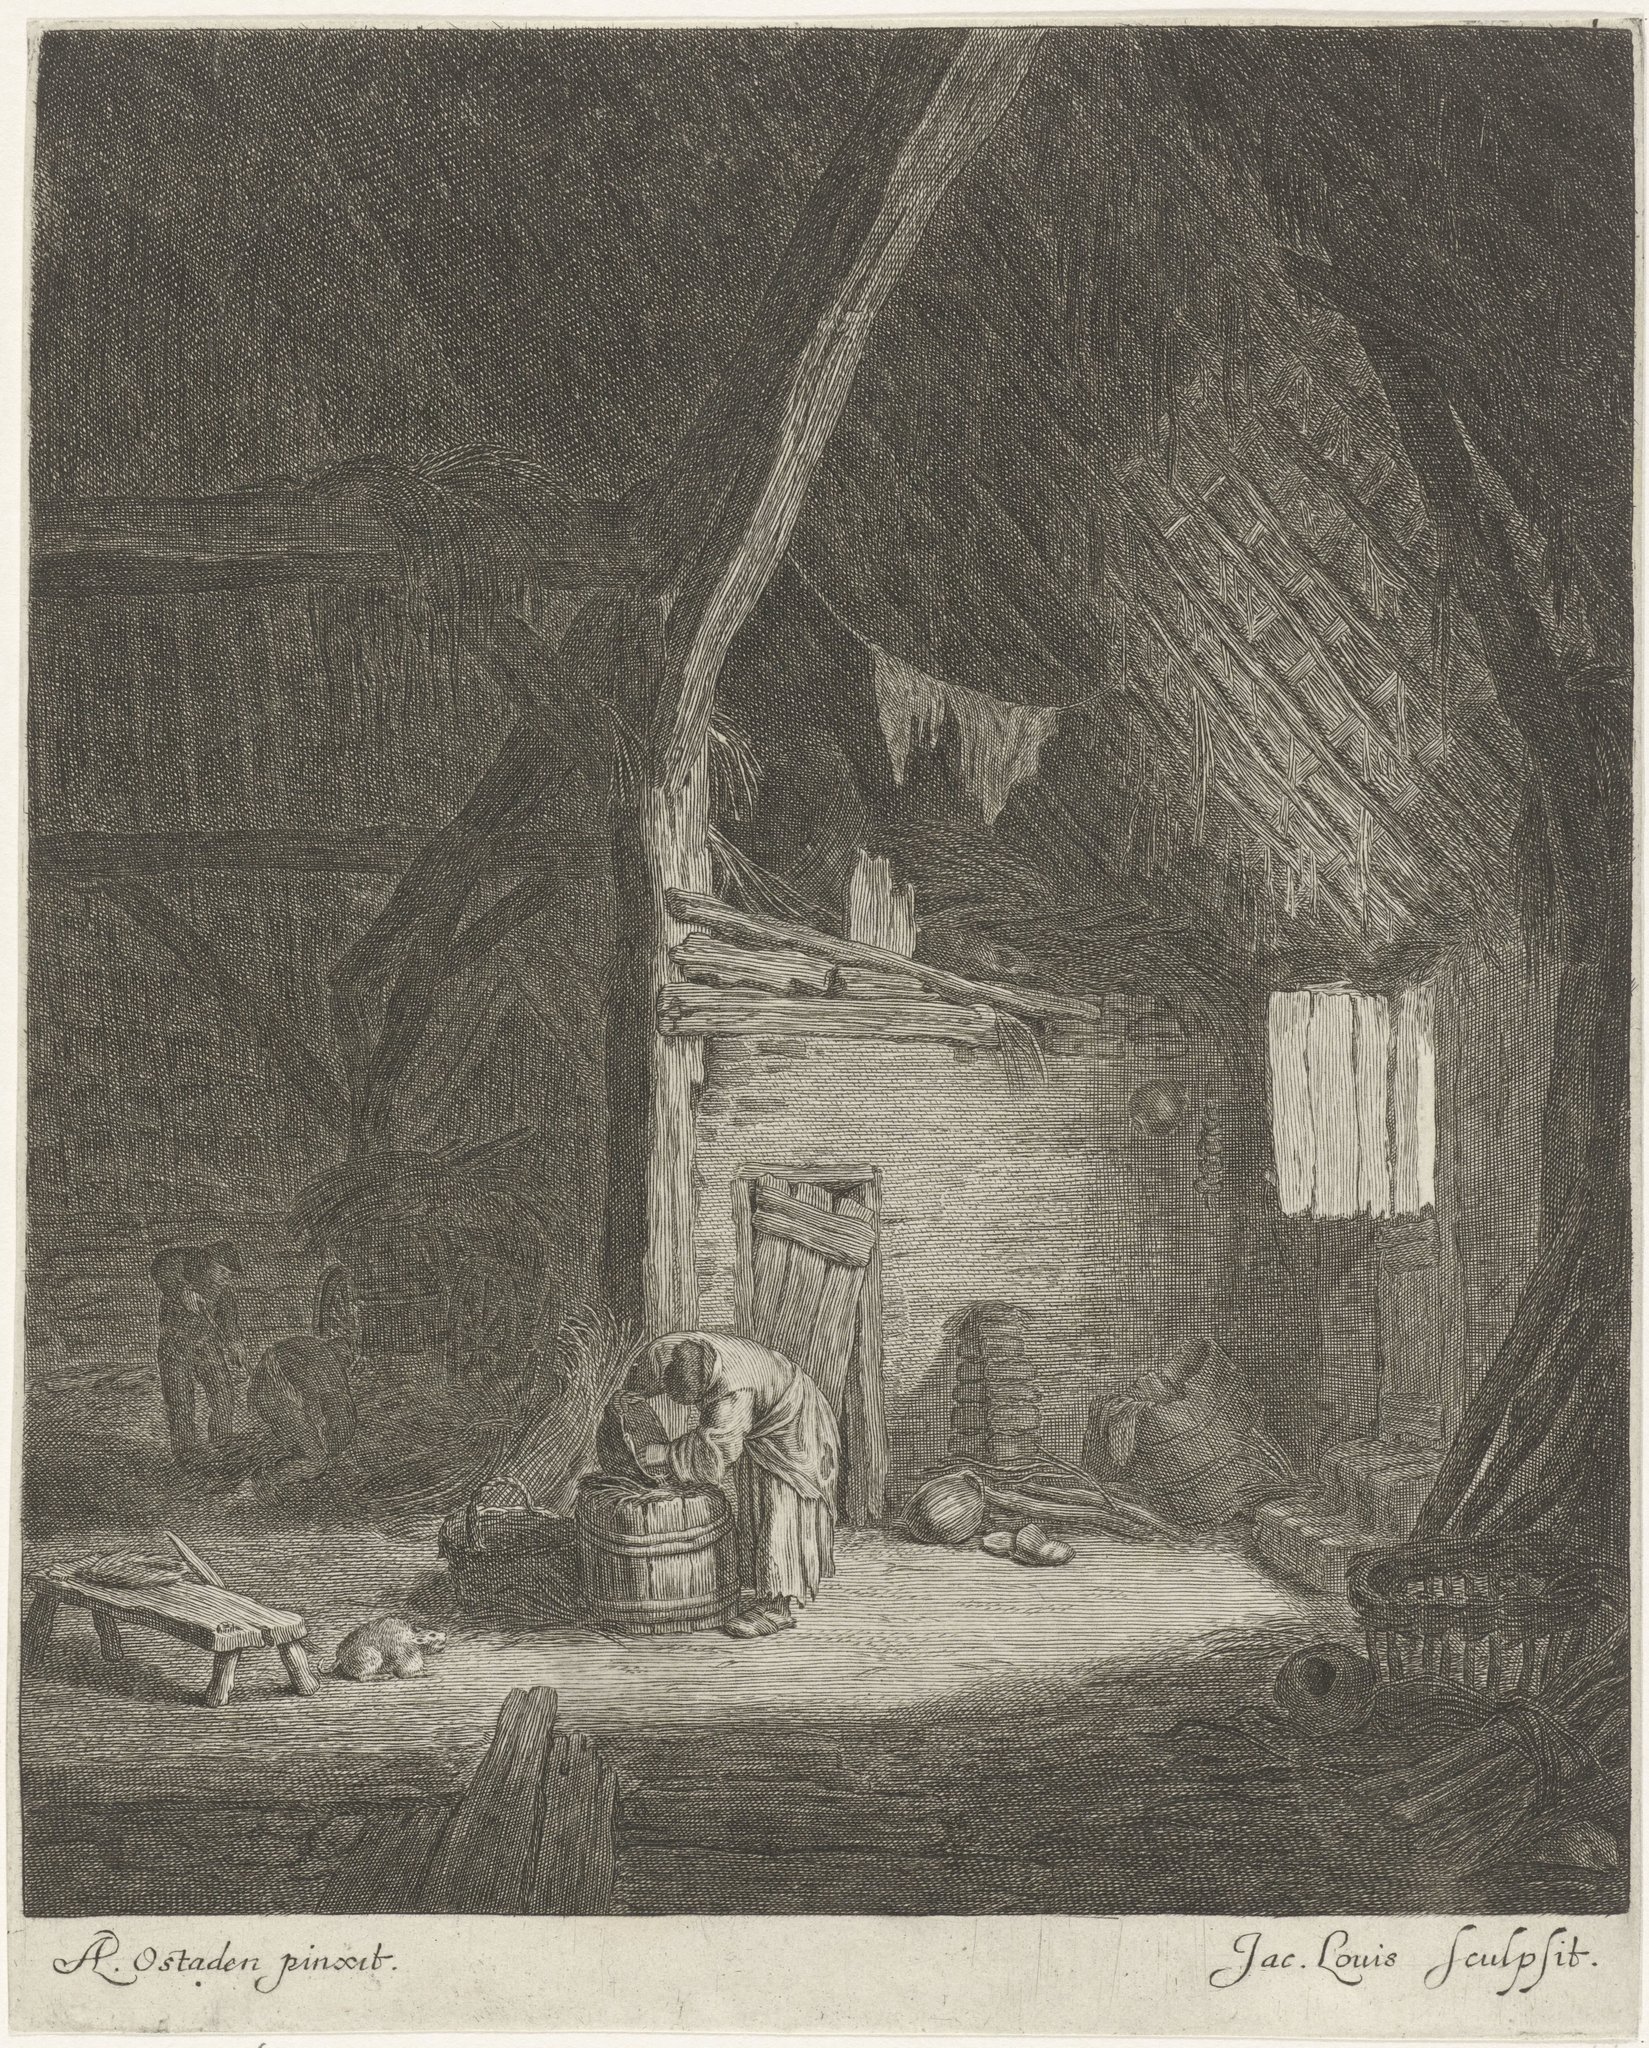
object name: print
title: Boereninterieur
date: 1630-1673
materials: paper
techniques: etching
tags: farm (building) - aa - civic architecture: inside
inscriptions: collector's mark: Lugt 2760, collector's mark: Lugt 2228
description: Boereninterieur met een boerin die een ketel schoonmaakt, links op de achtergrond zijn twee figuren aan het werk.